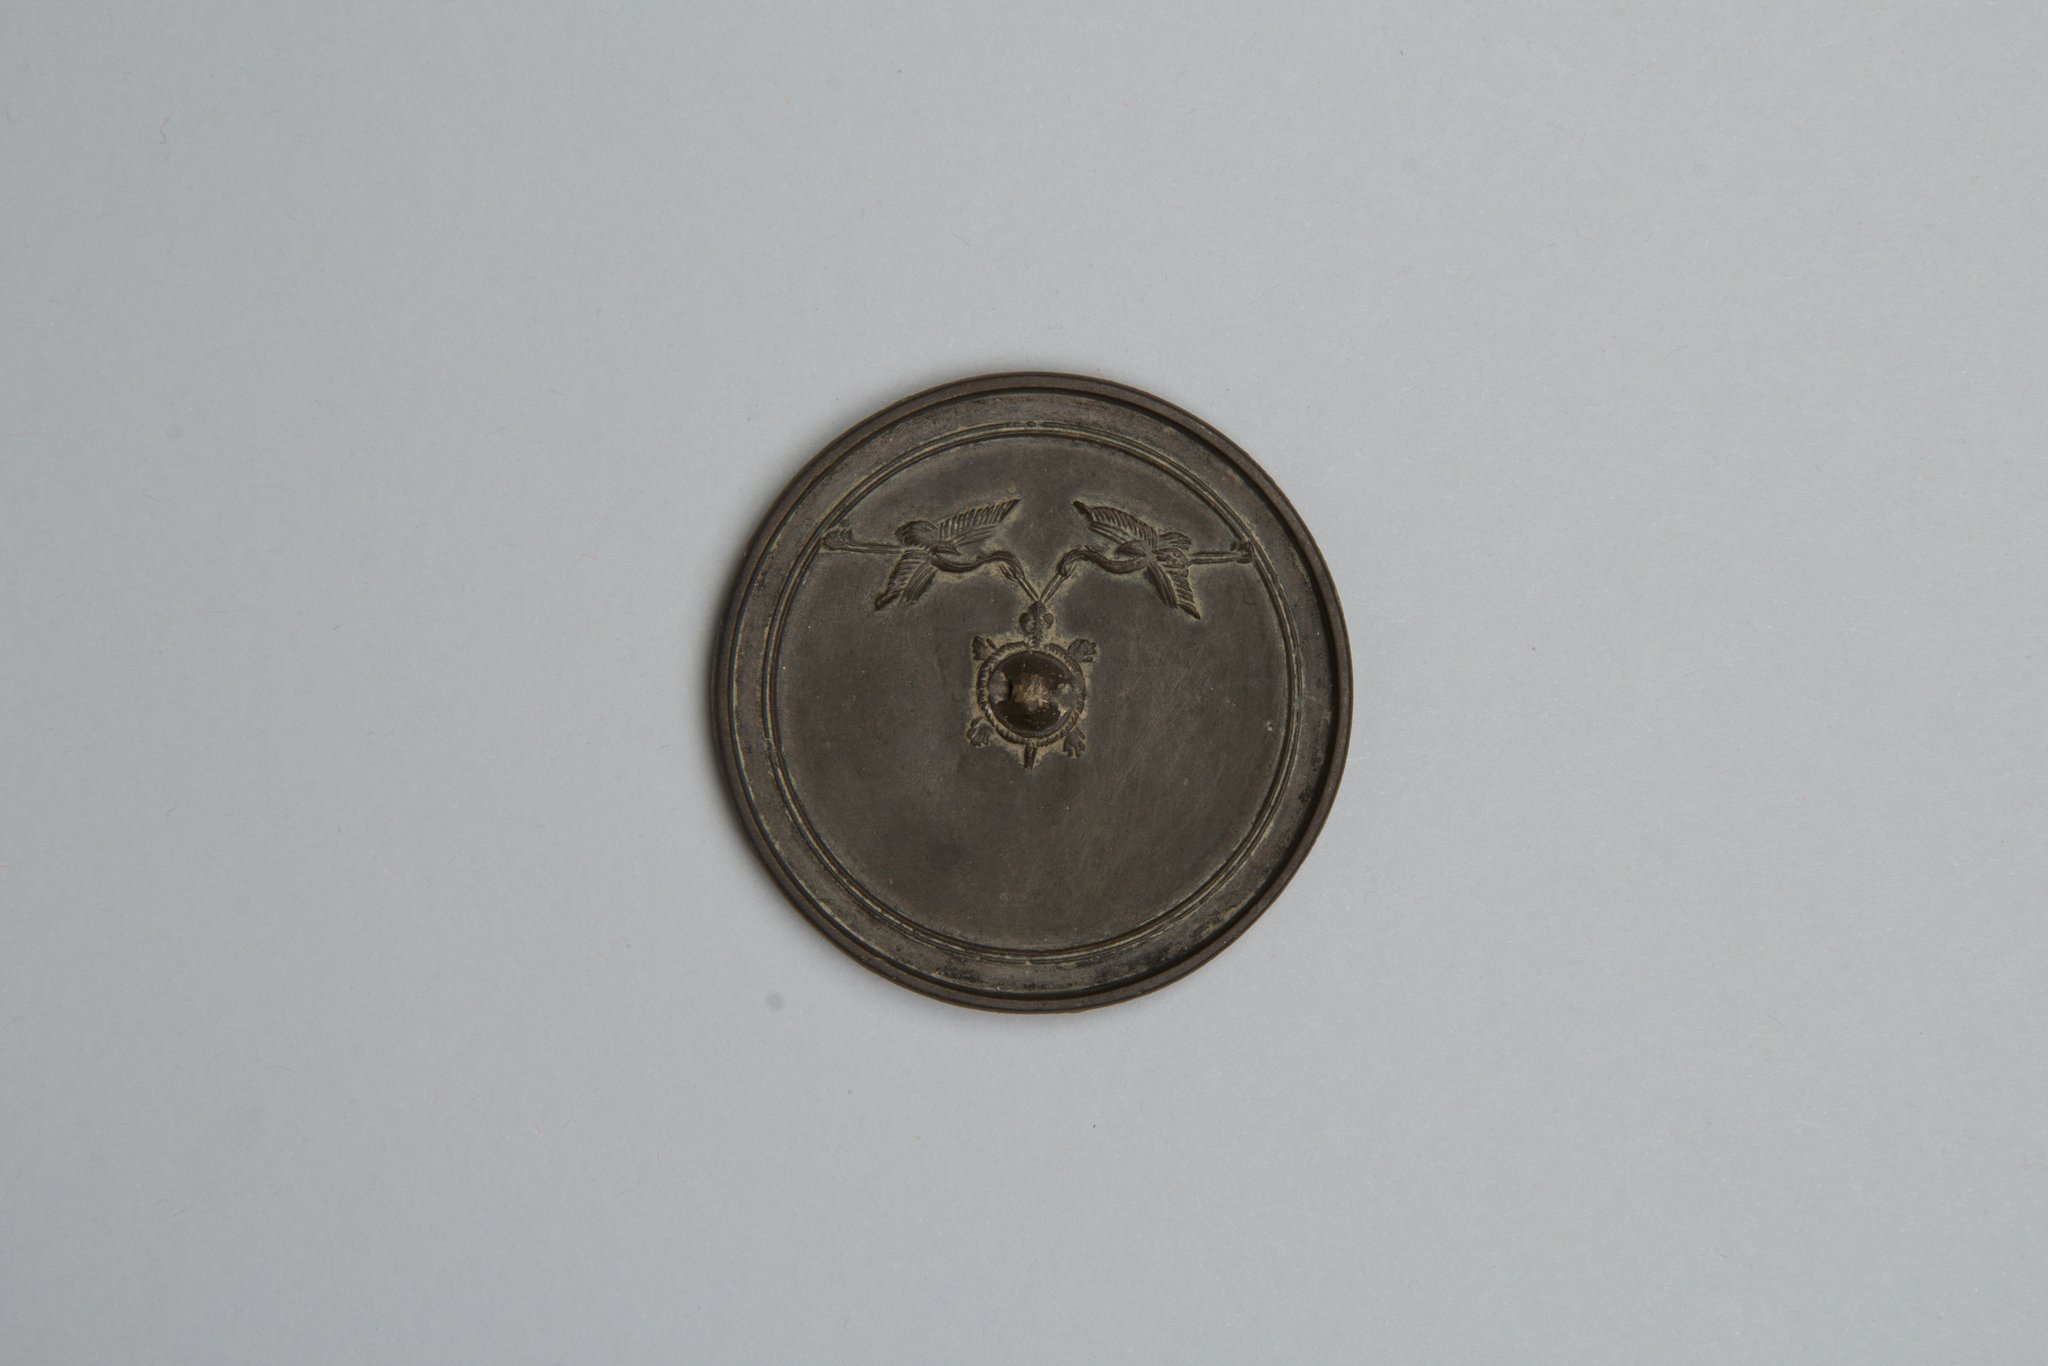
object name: mirror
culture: japanese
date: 1336-1573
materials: bronze